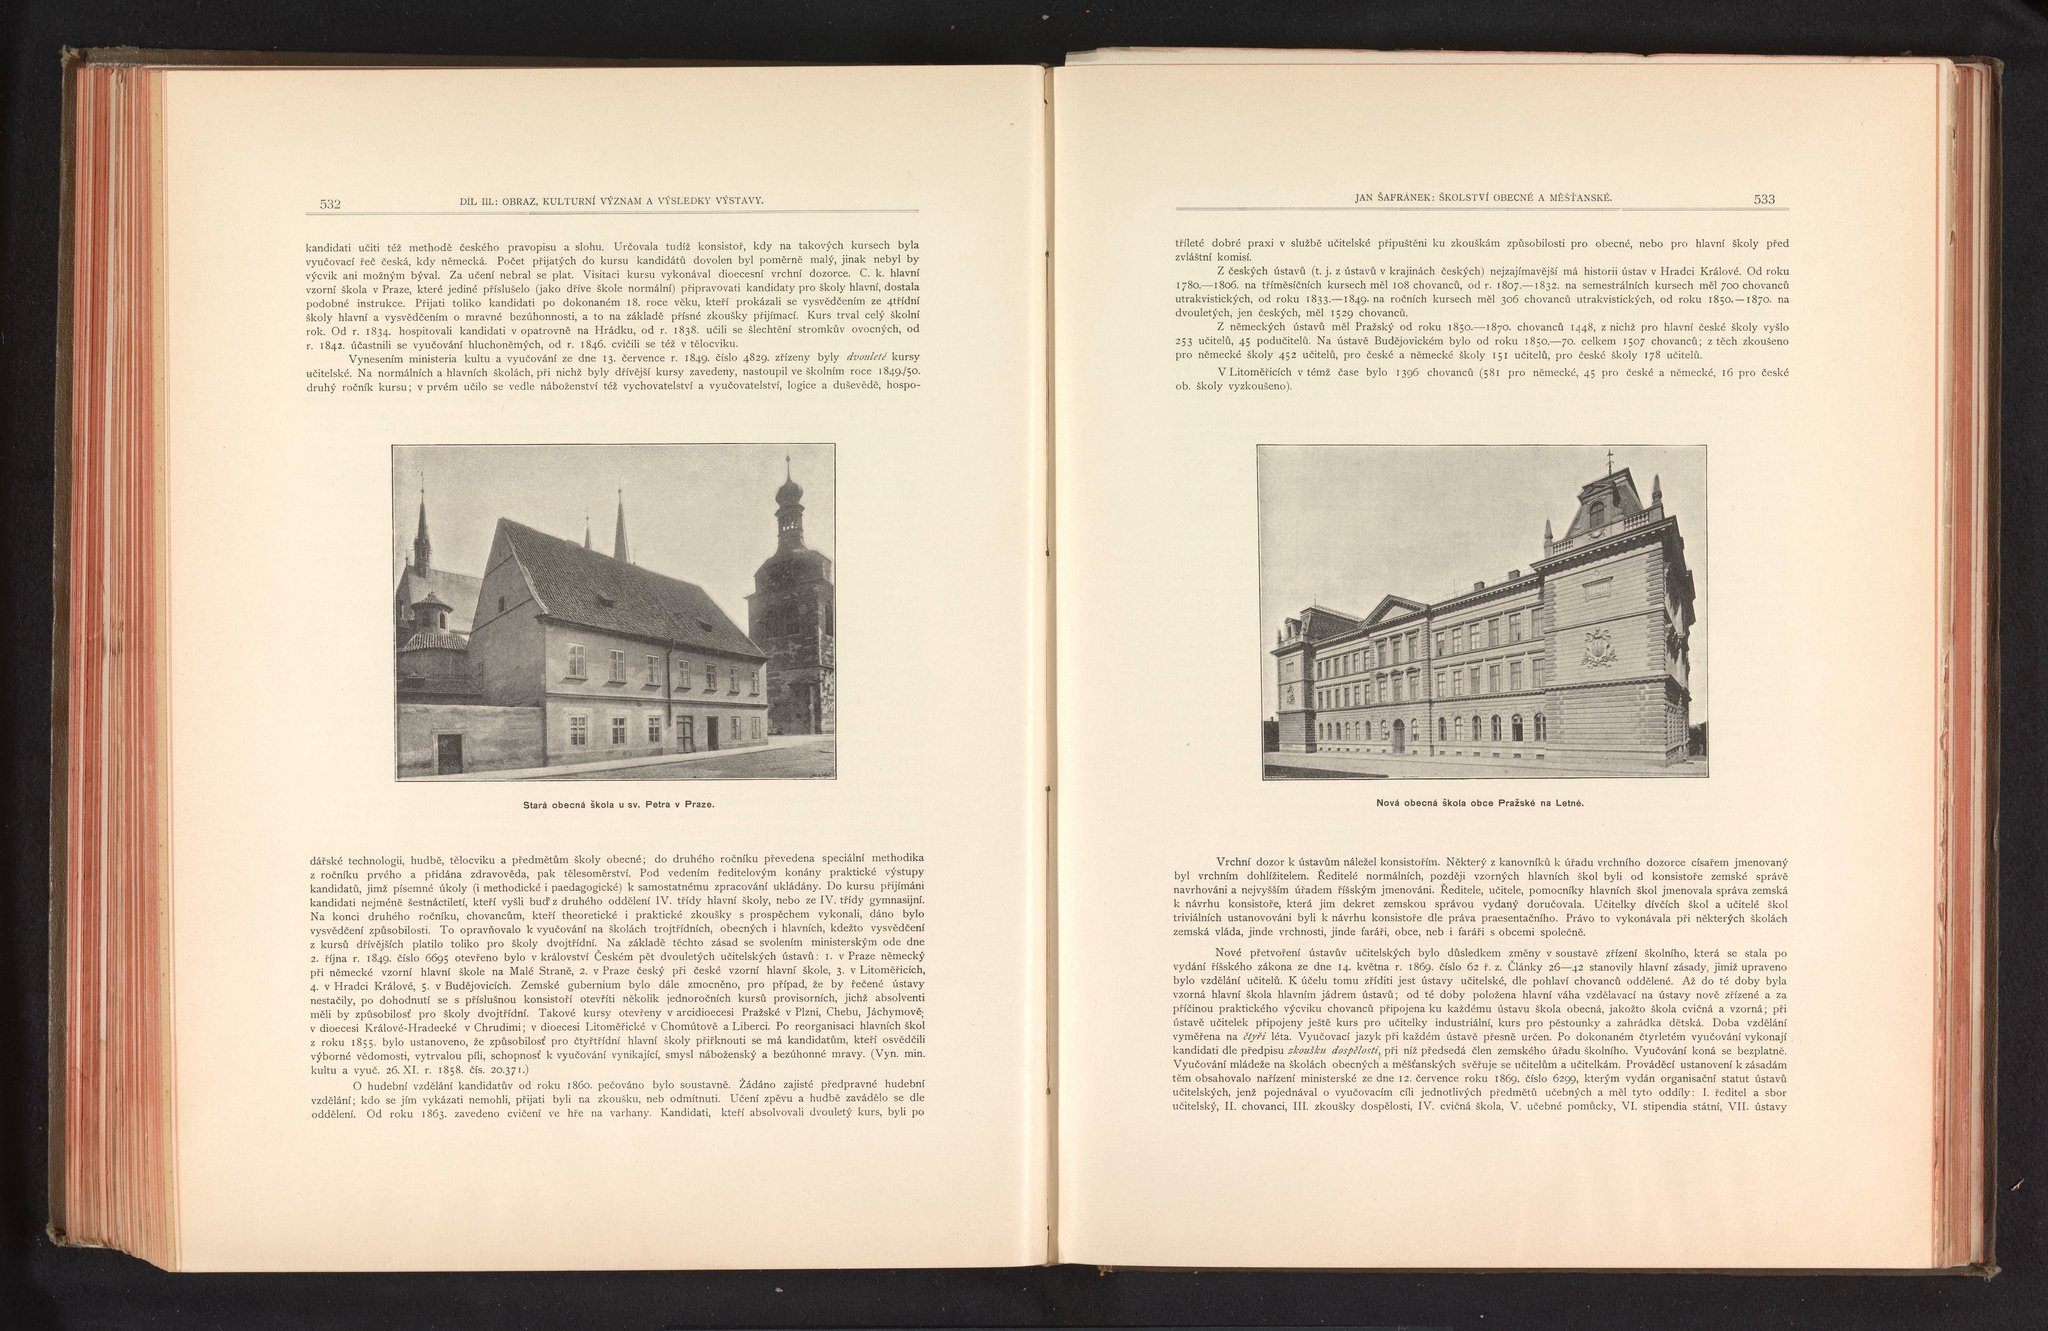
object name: page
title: Stará obecná skola u sv. Petra v Praze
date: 1891-1895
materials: paper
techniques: autotype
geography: prague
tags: façade (of house or building), elementary school; class, form